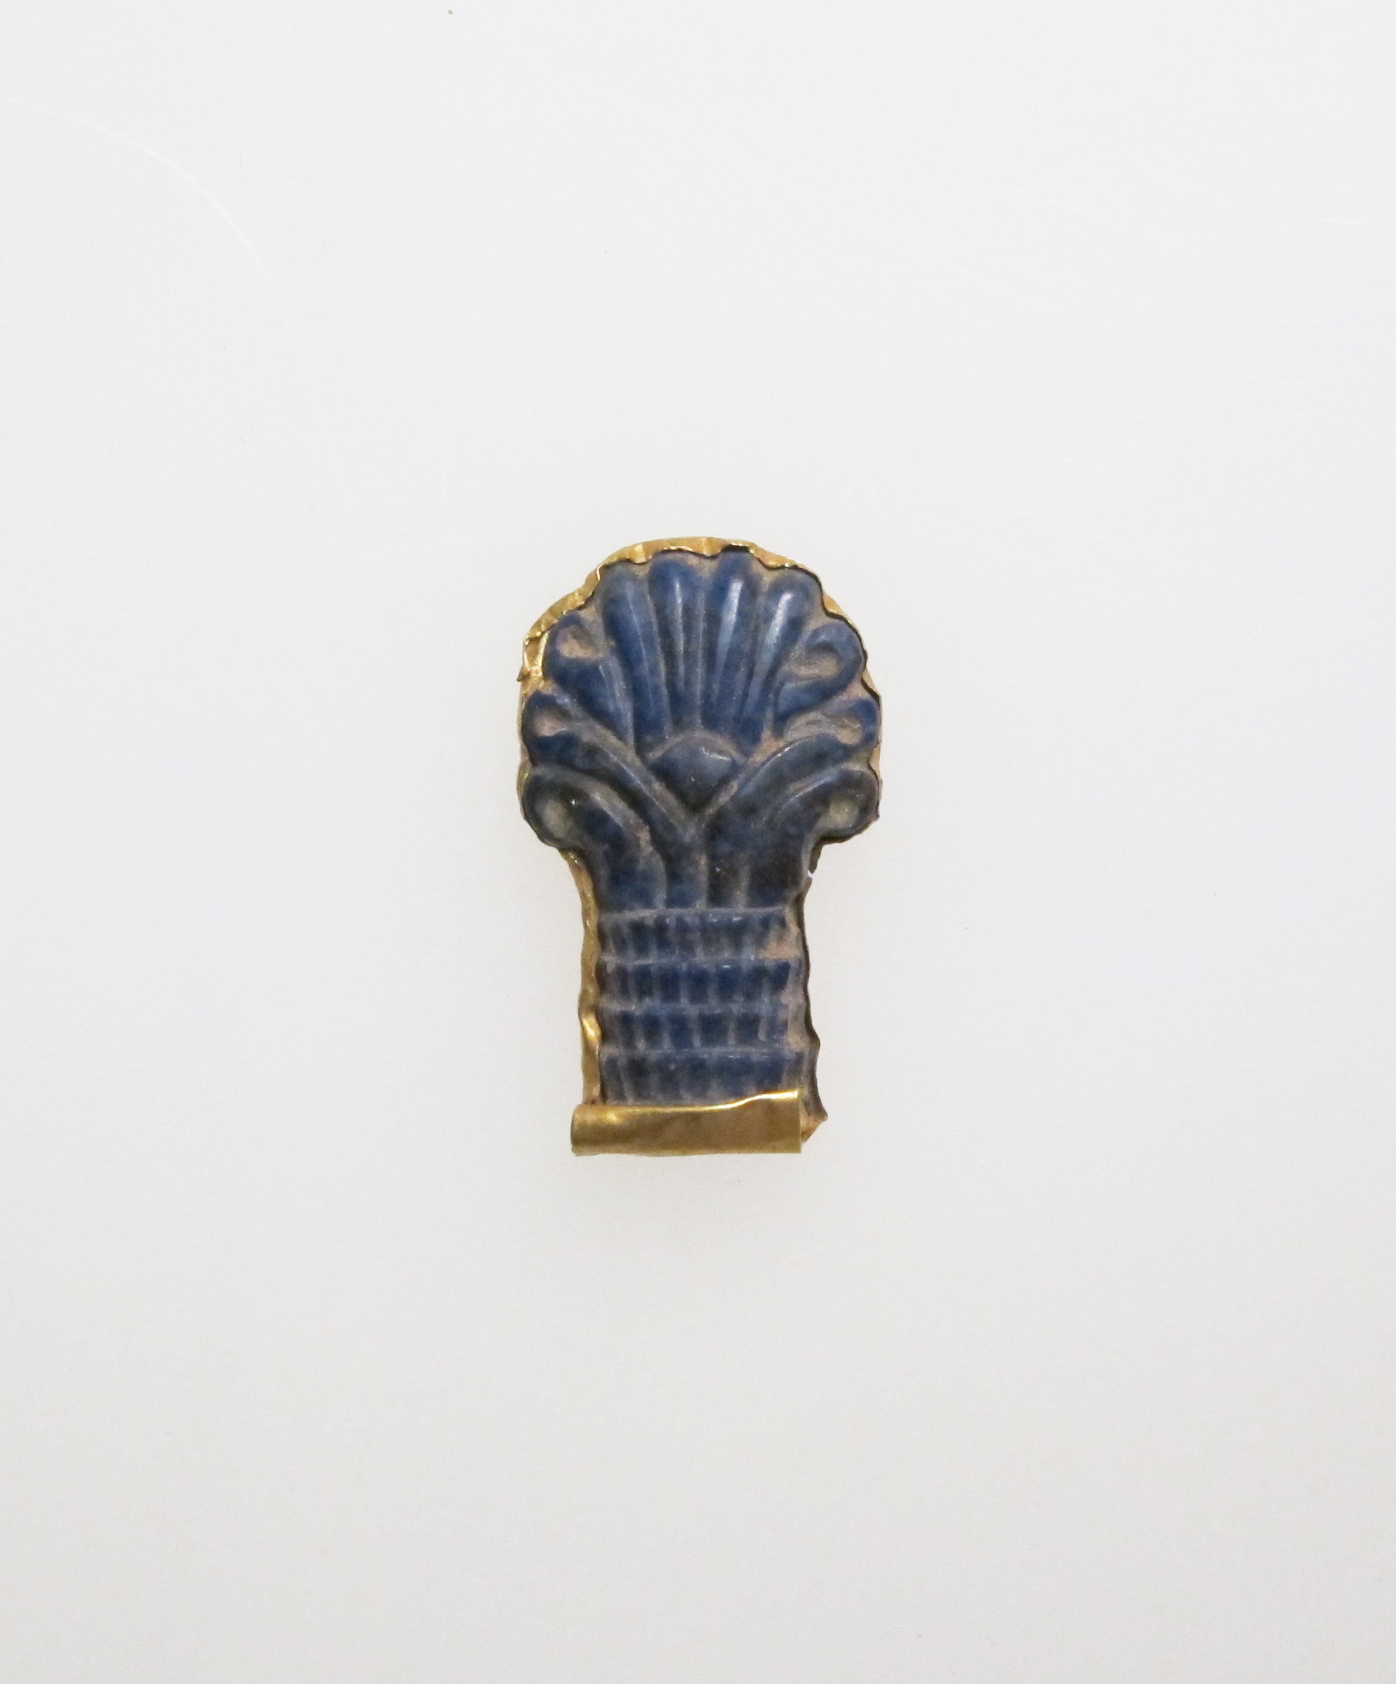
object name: bead ornament with lapis lazuli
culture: roman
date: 670 BCE-330 CE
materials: gold, lapis lazuli